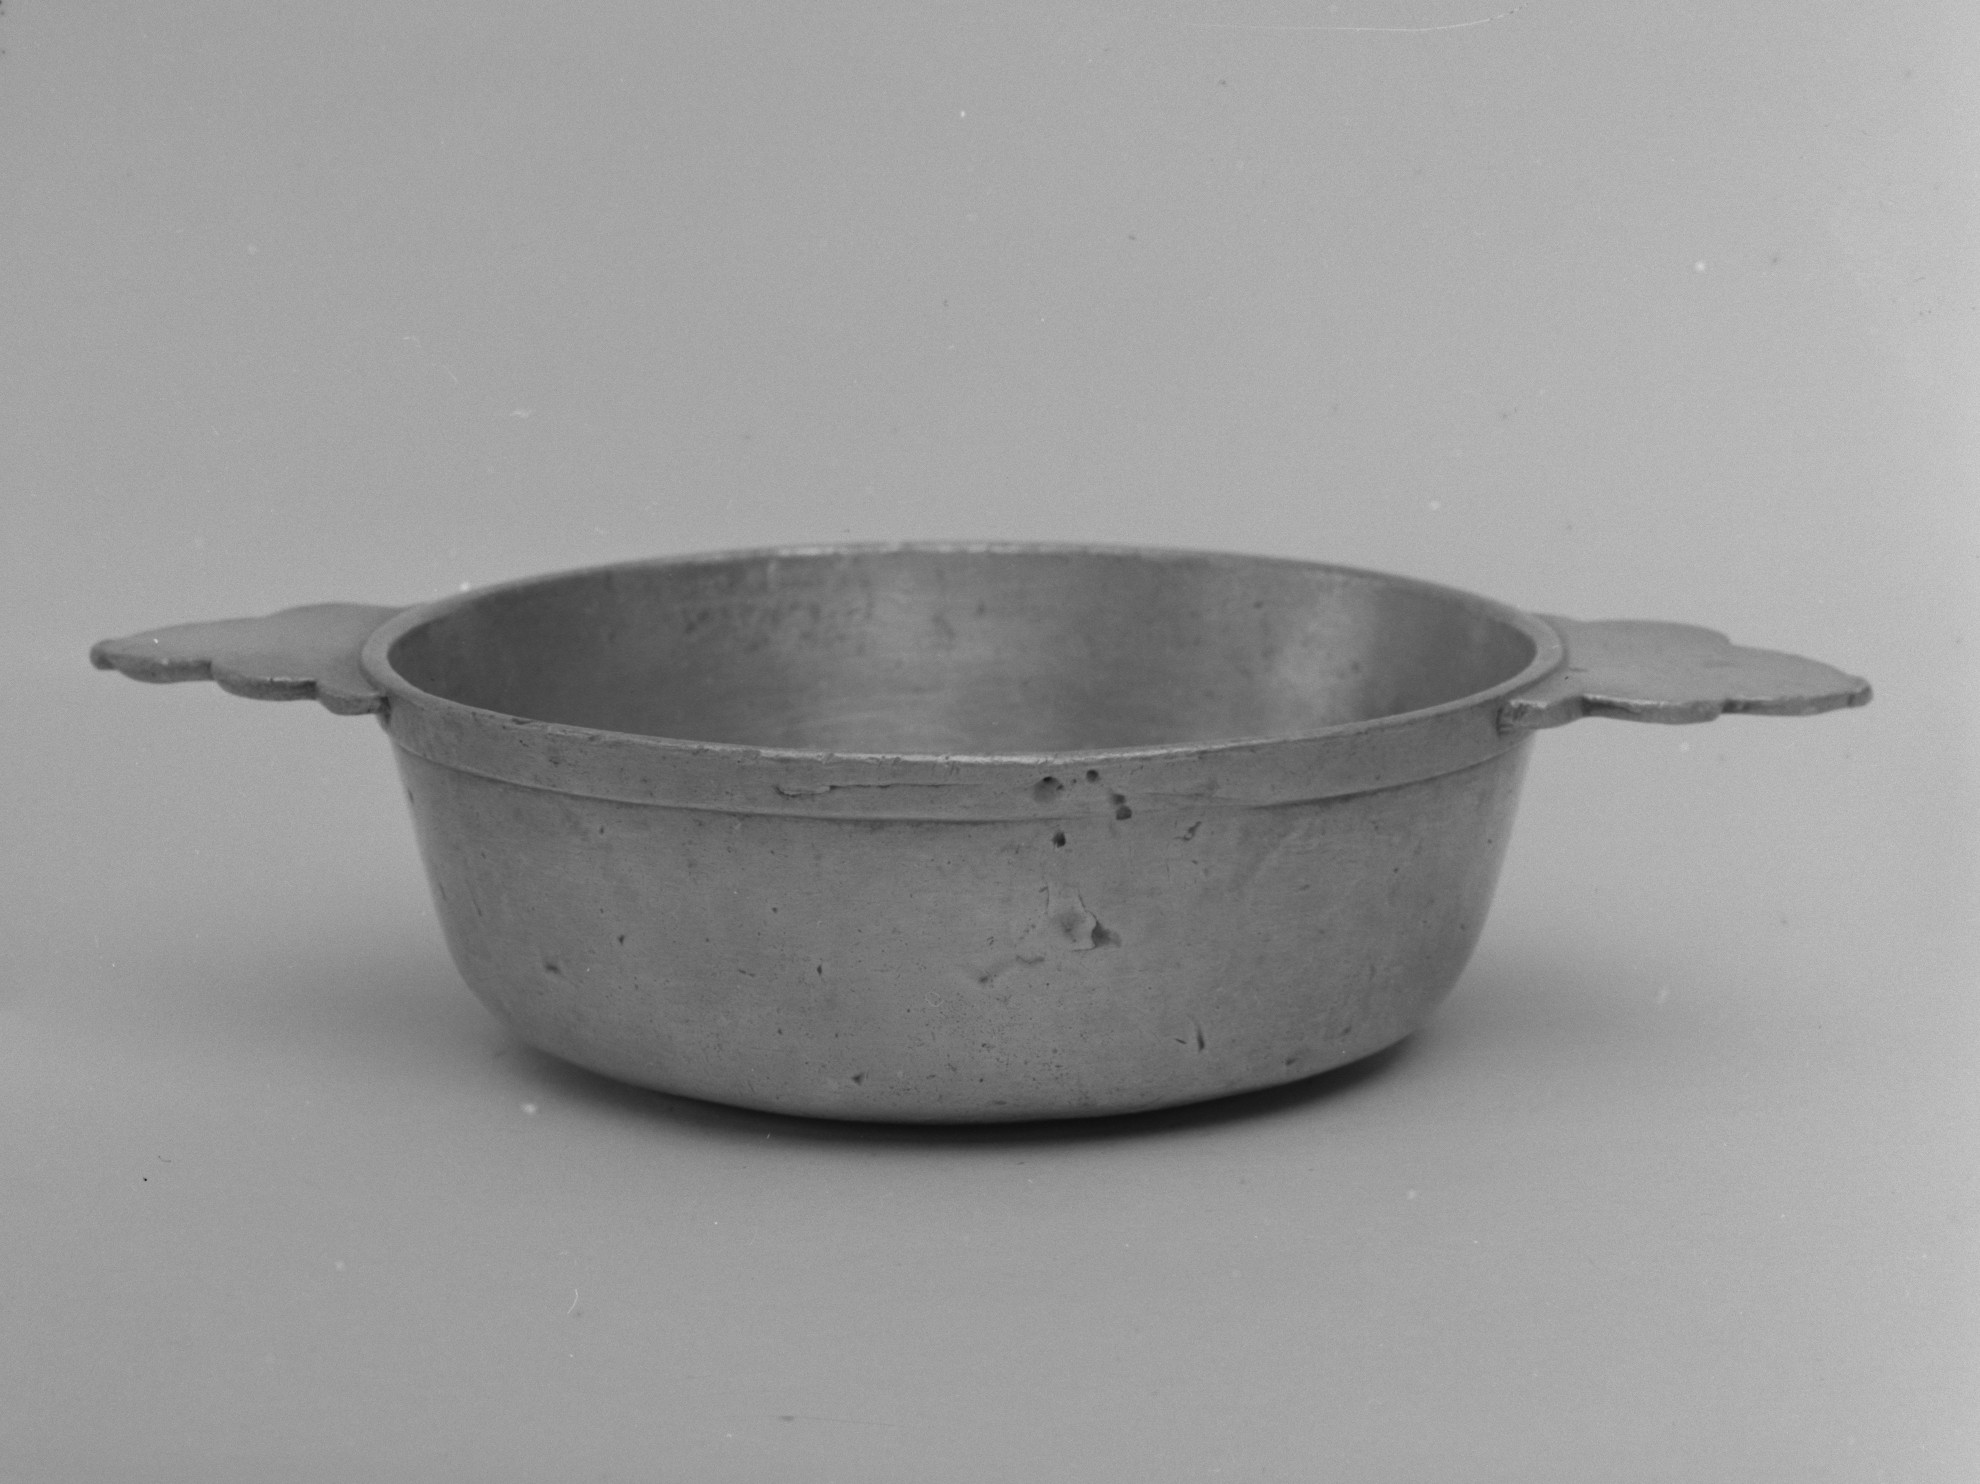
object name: bowl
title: Bowl (from set of four)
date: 1701-1800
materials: pewter